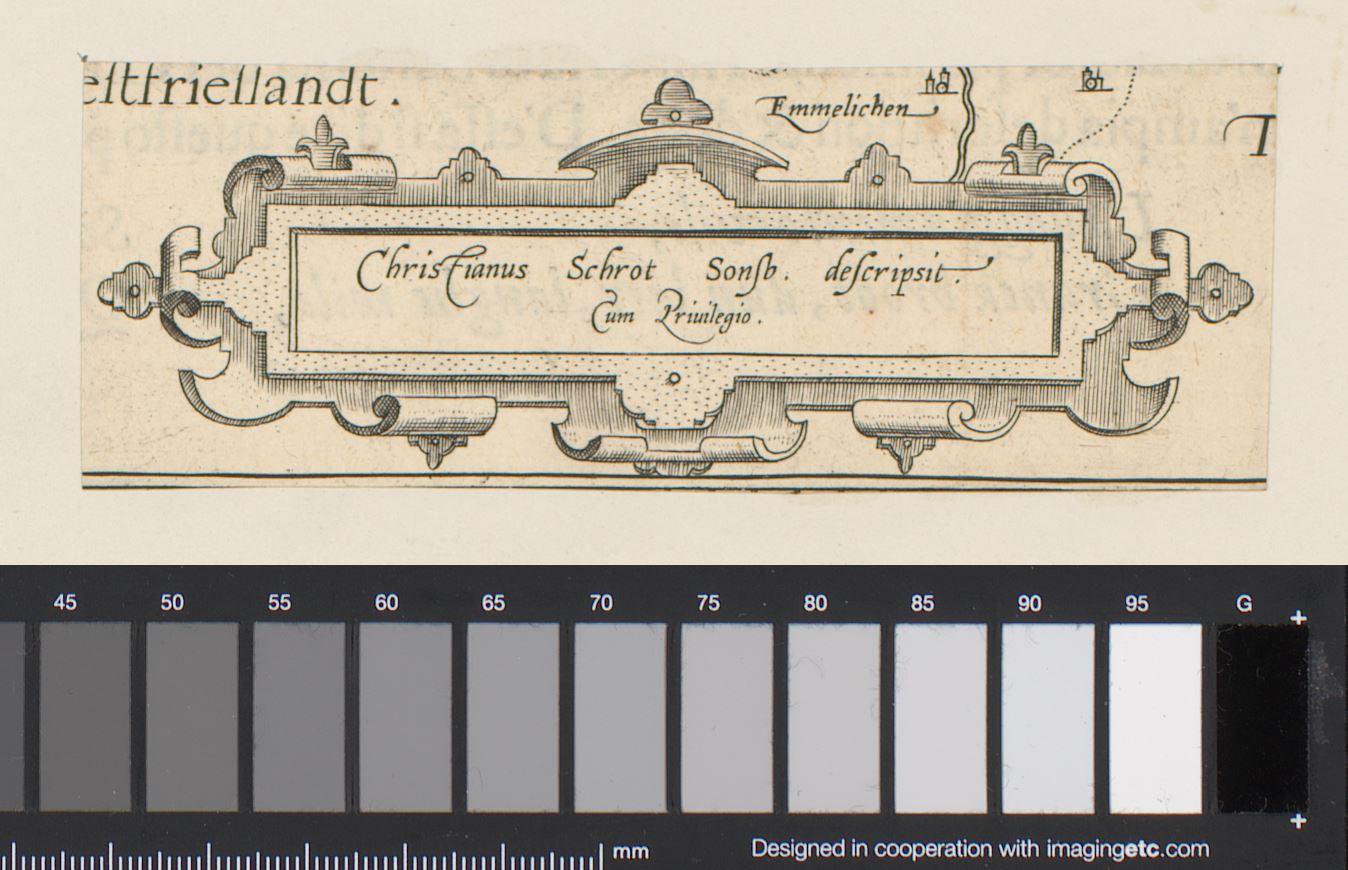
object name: album leaf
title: Langwerpige cartouche met rolwerk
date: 1579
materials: paper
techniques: engraving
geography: antwerp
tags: scrollwork, strapwork ~ ornament, ornament ~ cartouche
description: Langwerpige cartouche met rolwerk. Het betreft een fragment van een kaart van Westfalen. De prent maakt deel uit van een album.